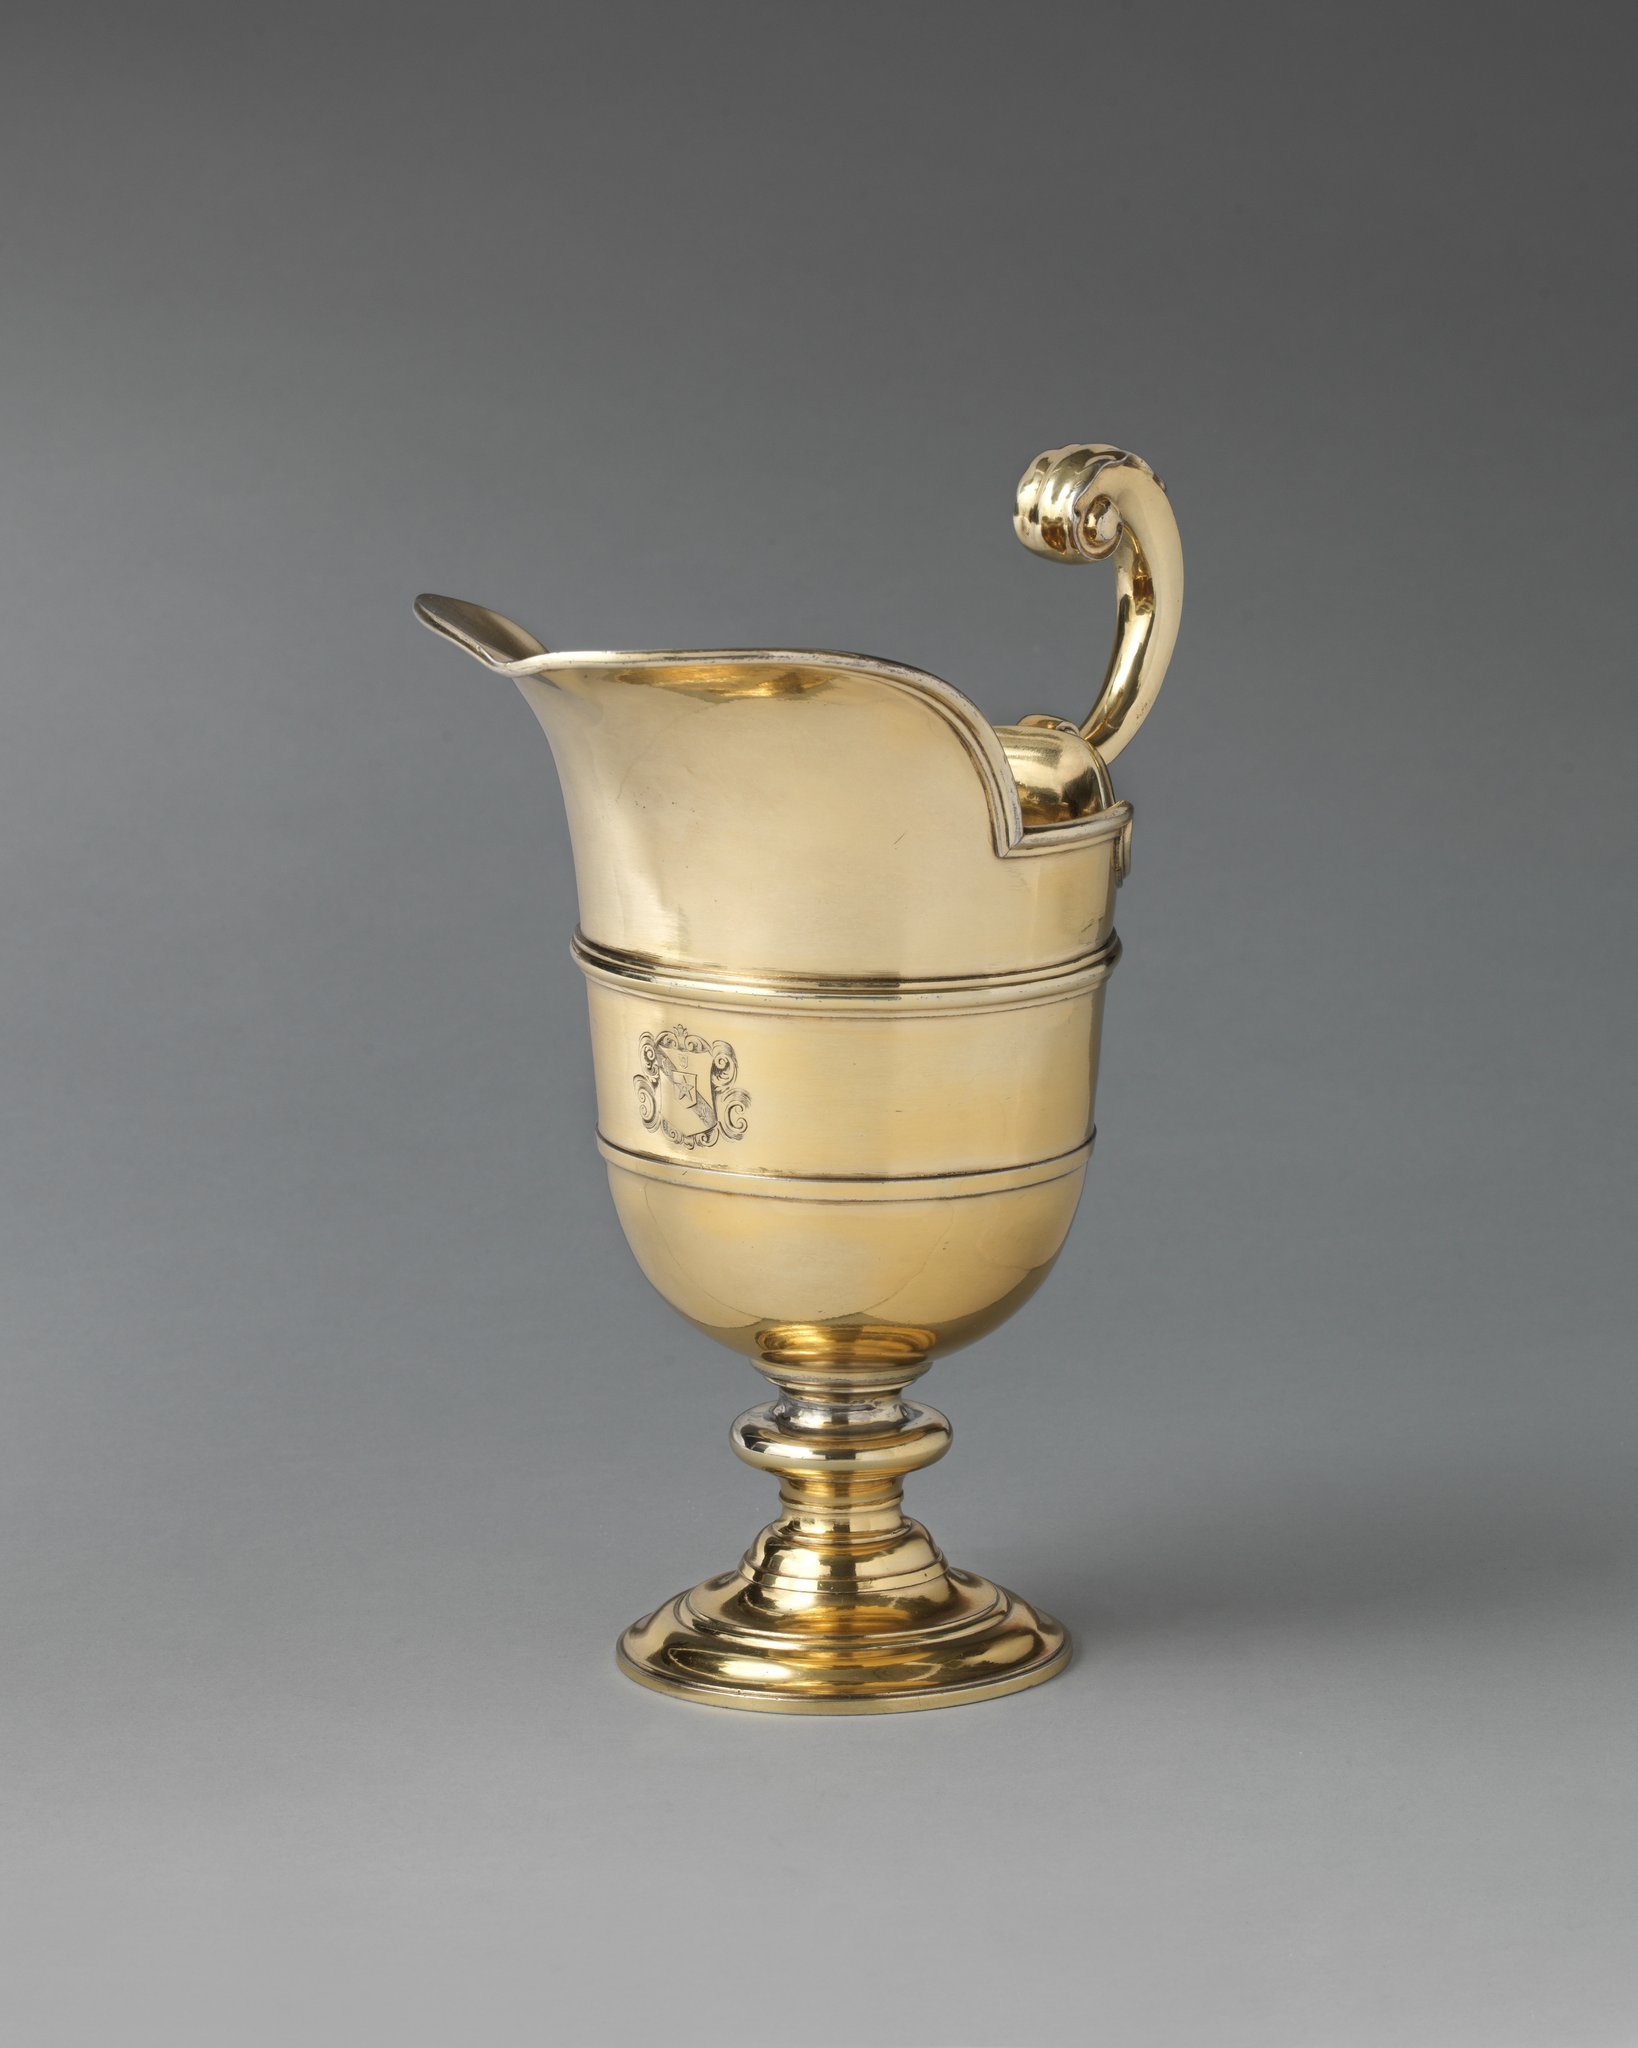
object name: ewer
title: Ewer (part of a set)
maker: simon pantin i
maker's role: maker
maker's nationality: british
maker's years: 1672-1728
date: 1727-1728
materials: silver gilt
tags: coat of arms